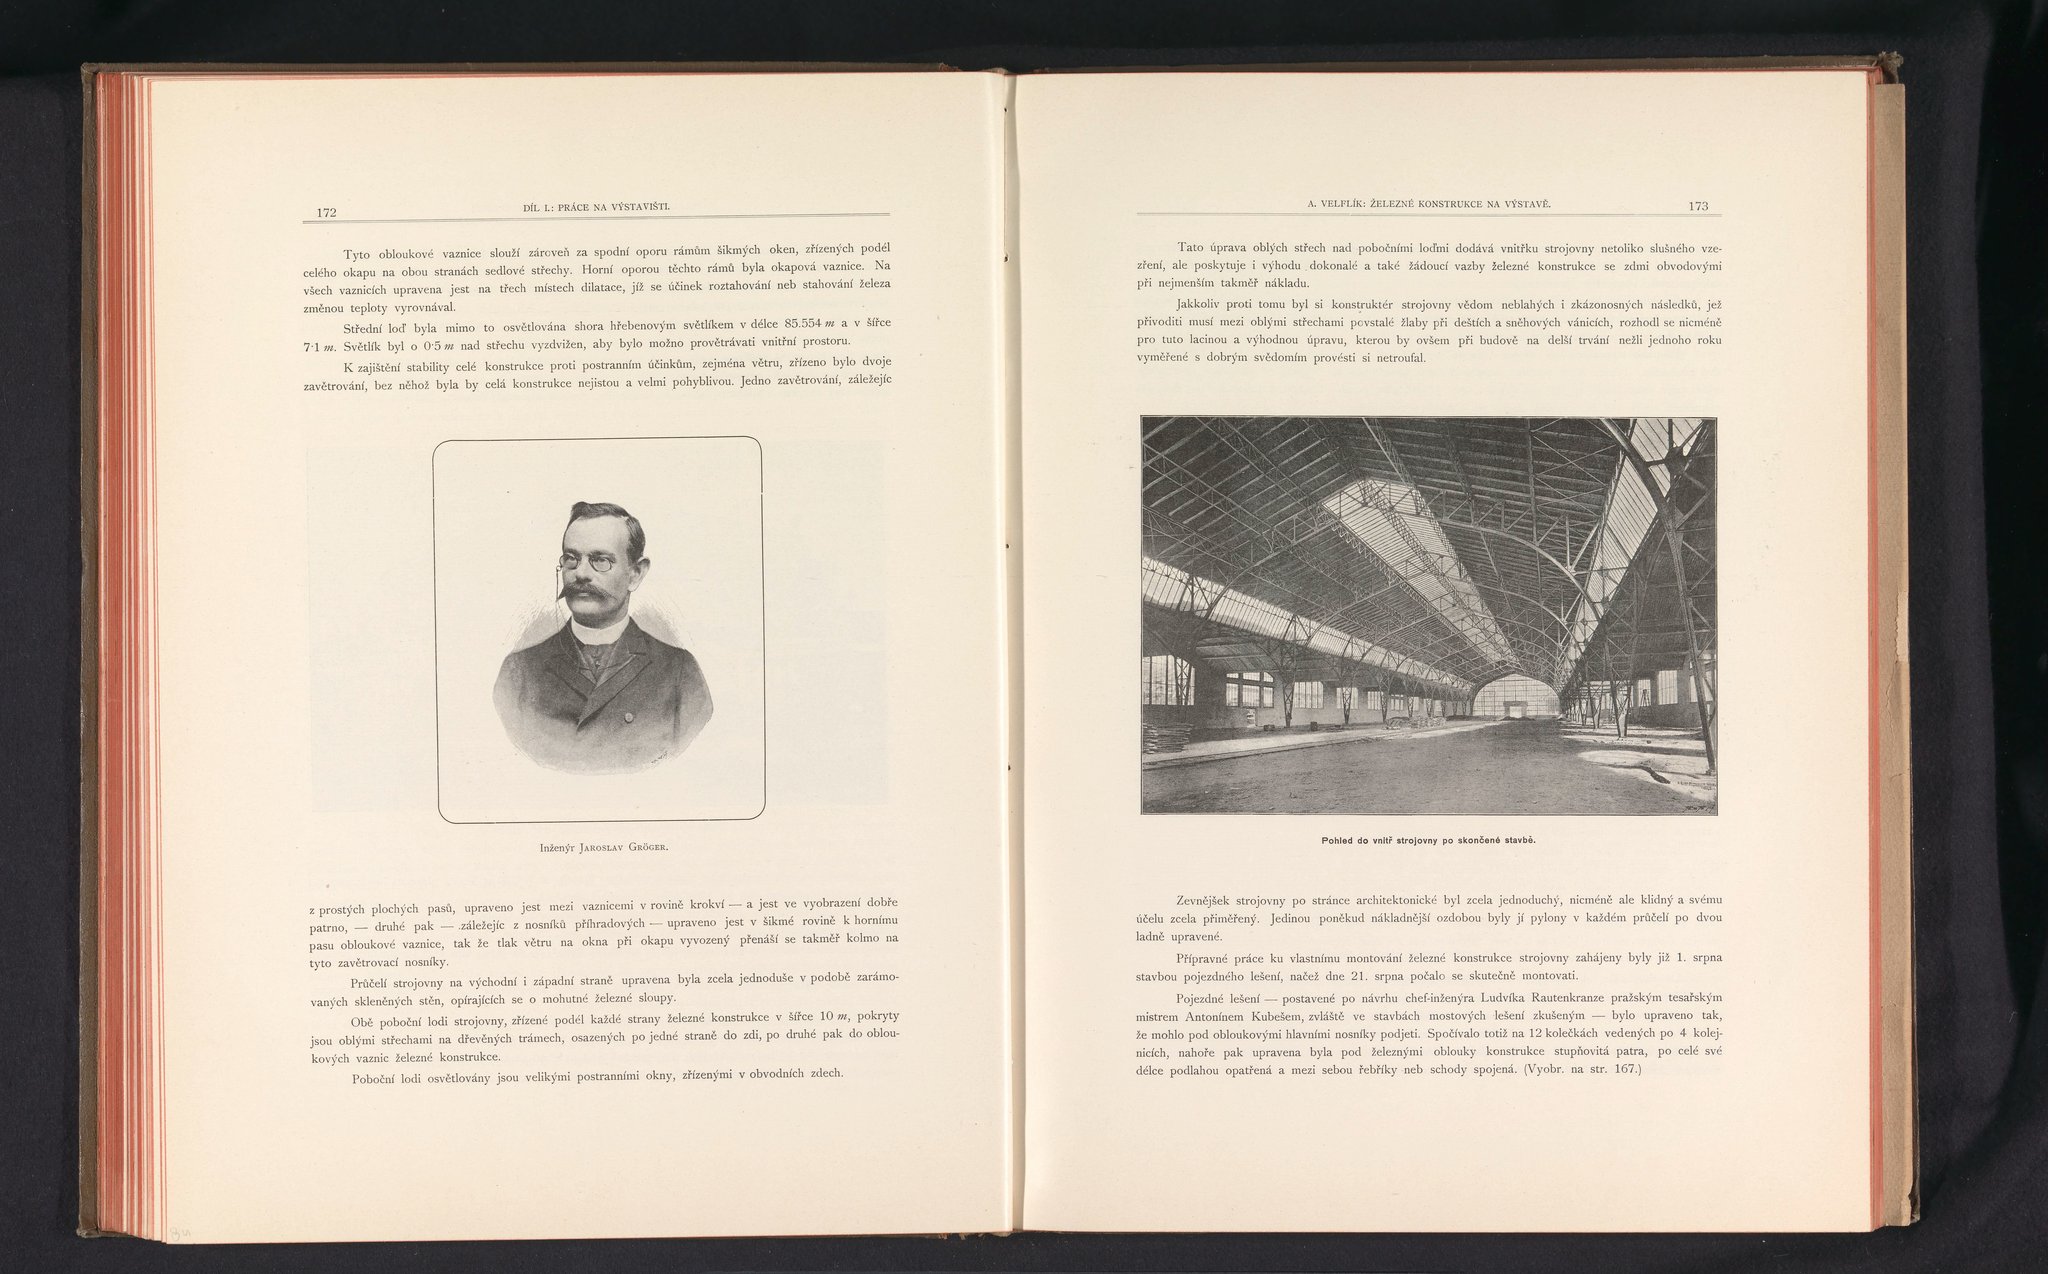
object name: photomechanical print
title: Inzenýr Jaroslav Gröger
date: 1888-1893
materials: paper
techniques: autotype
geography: prague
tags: adult man